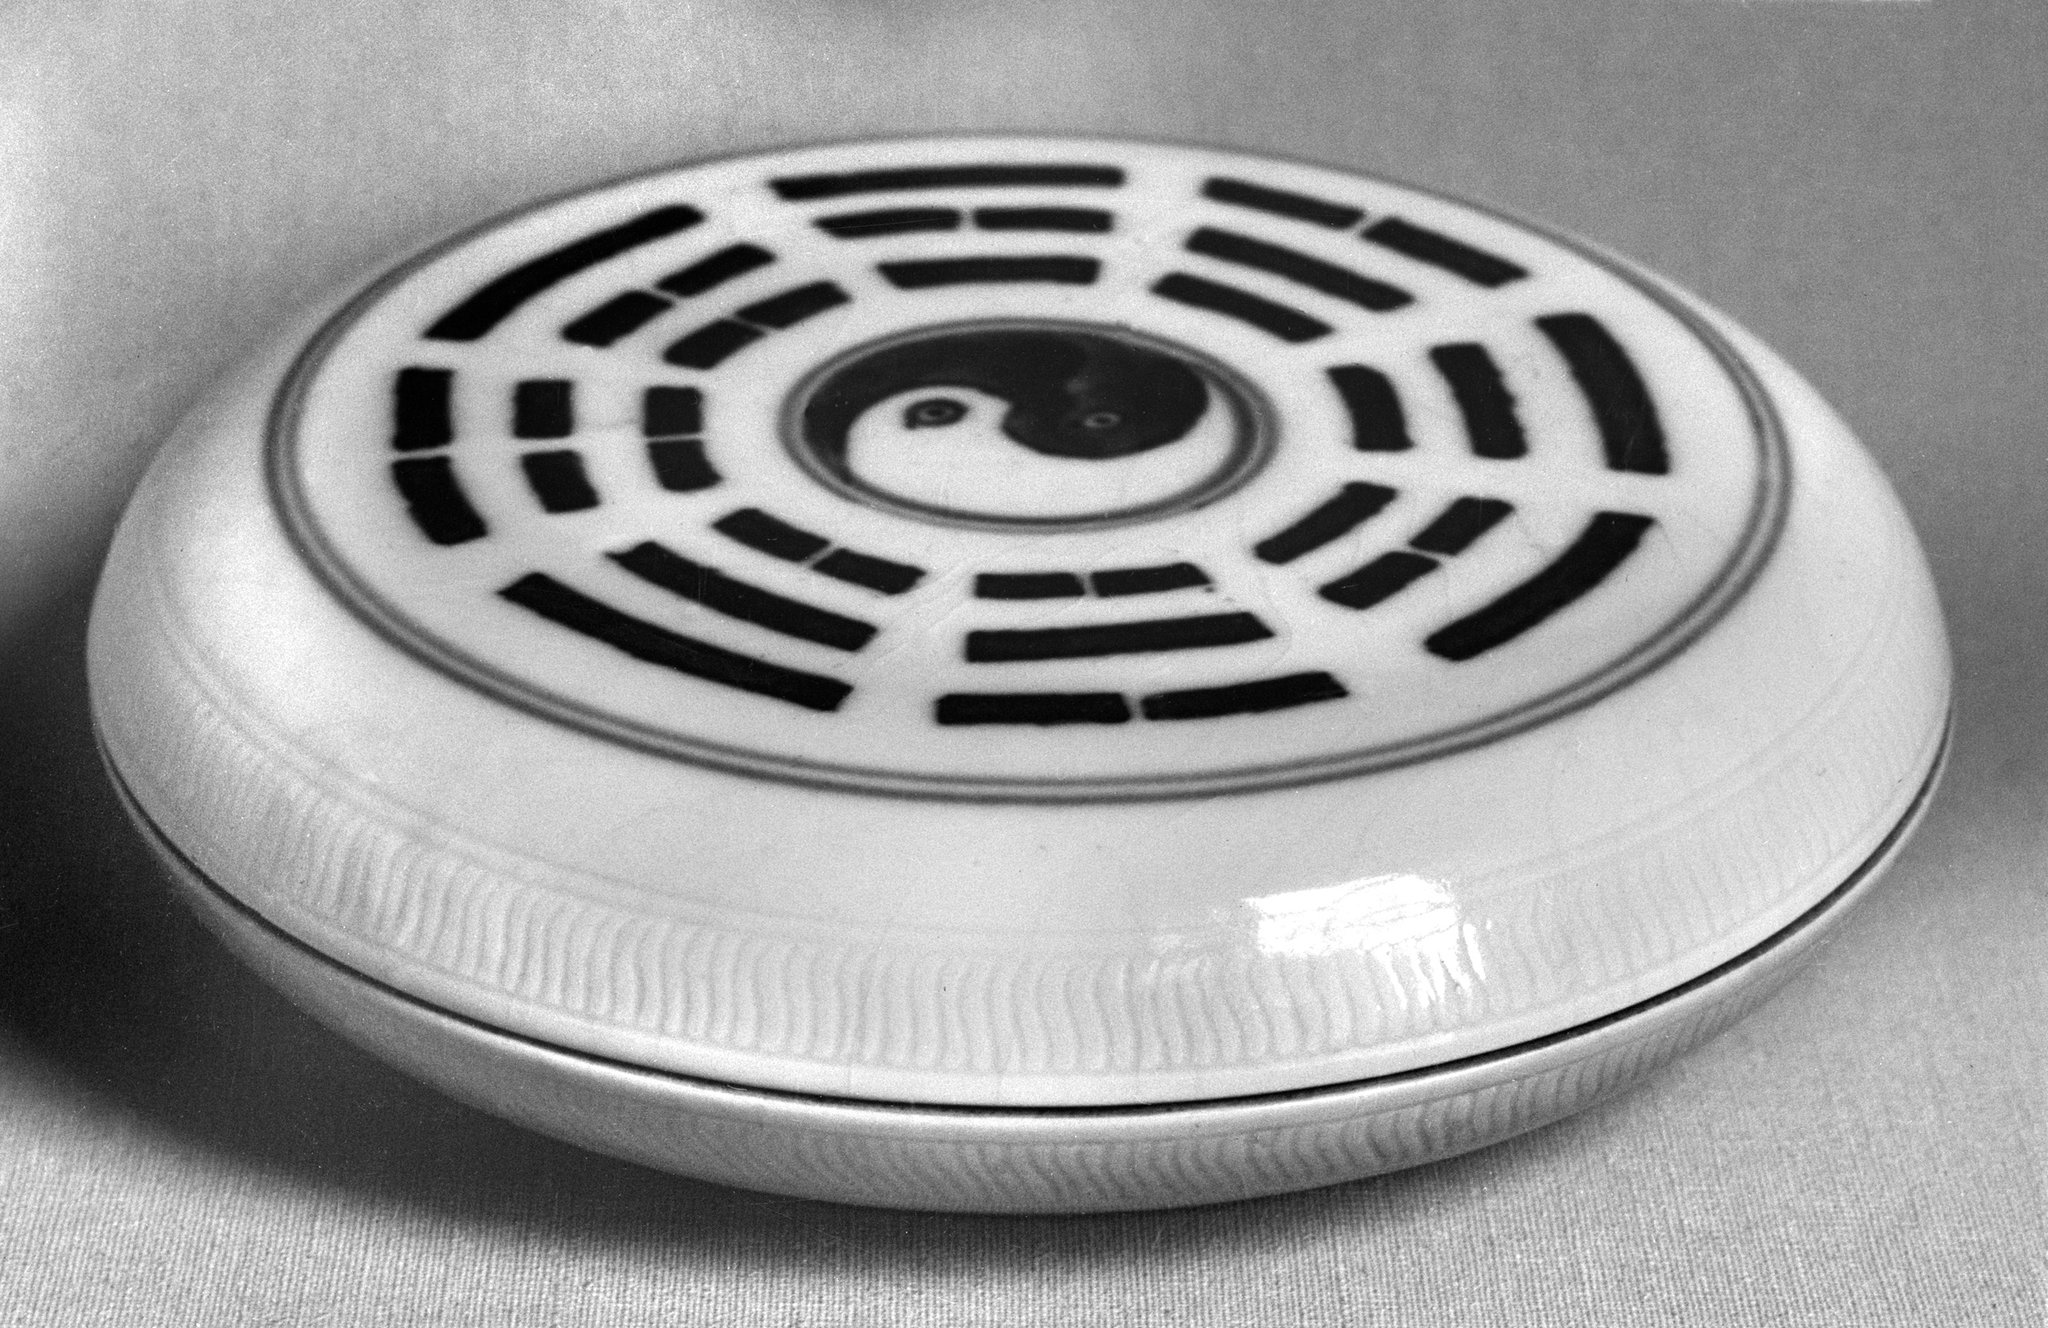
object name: seal paste box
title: Seal paste box with eight trigrams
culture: chinese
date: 1701-1800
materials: cobalt, soft paste porcelain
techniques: painting, underglaze